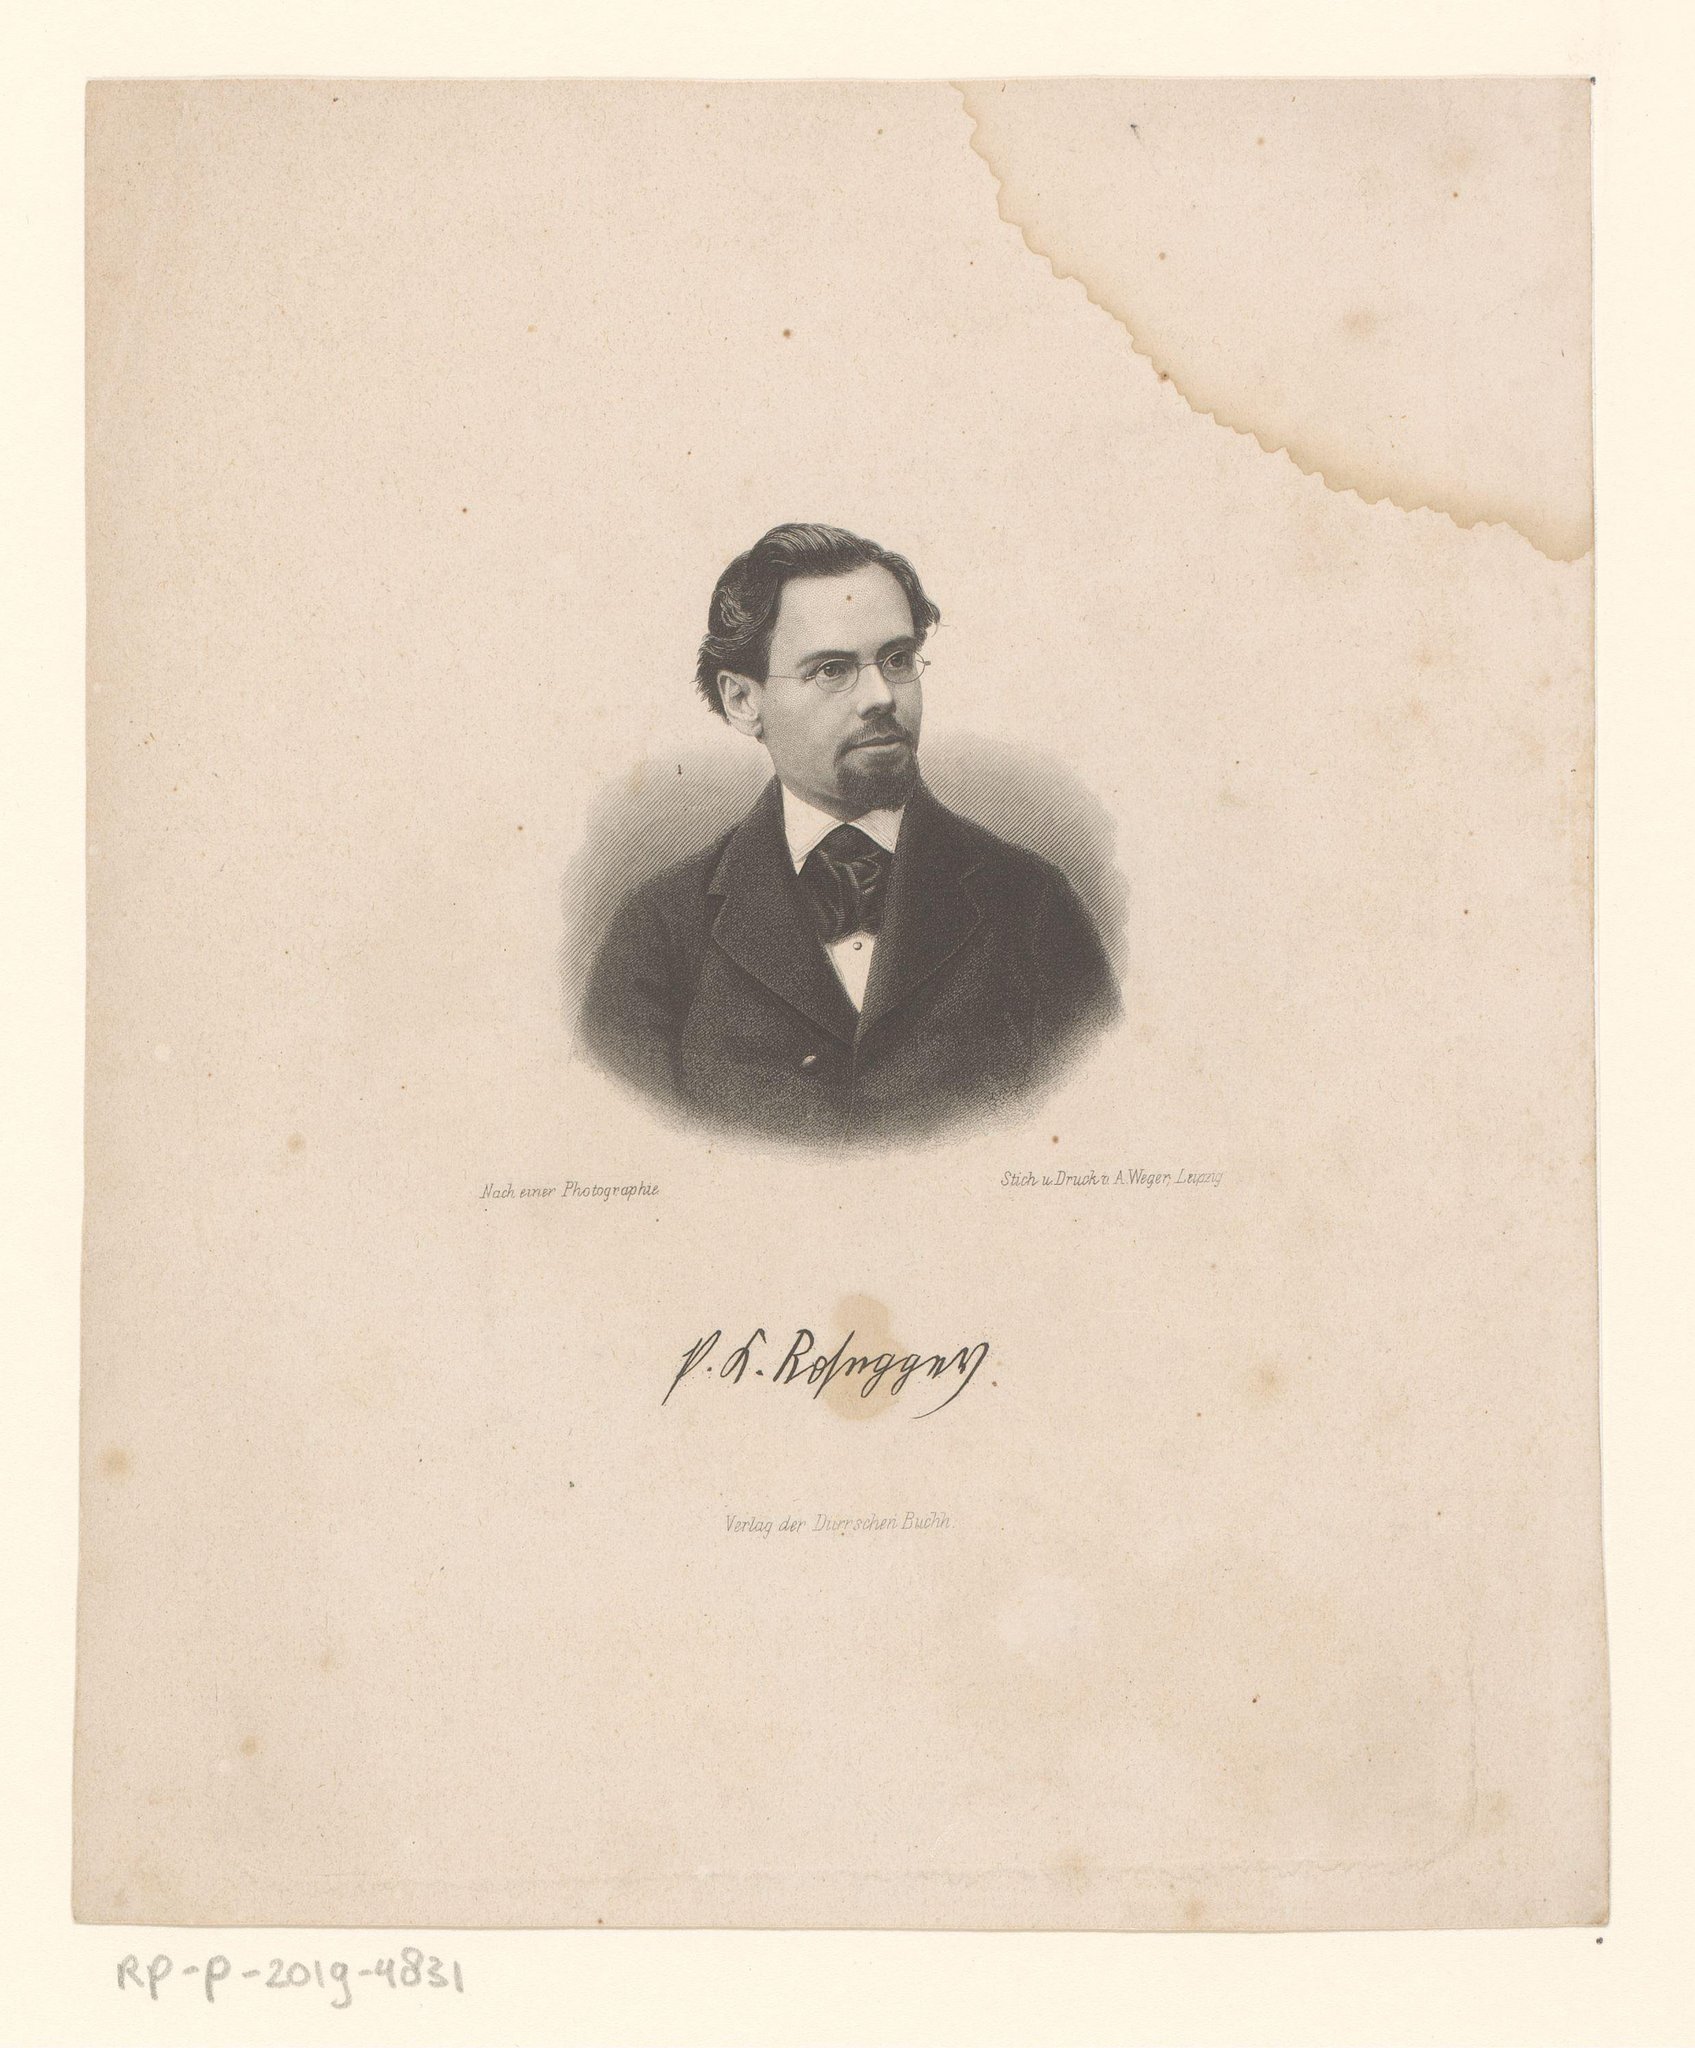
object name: print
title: P. L. Rosegger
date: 1878-1892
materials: paper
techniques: etching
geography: leipzig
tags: historical persons, portrait of a writer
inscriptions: collector's mark: Lugt 2228, collector's mark: ‘Franz Radestom [?]’, collector's mark: Lugt 2760